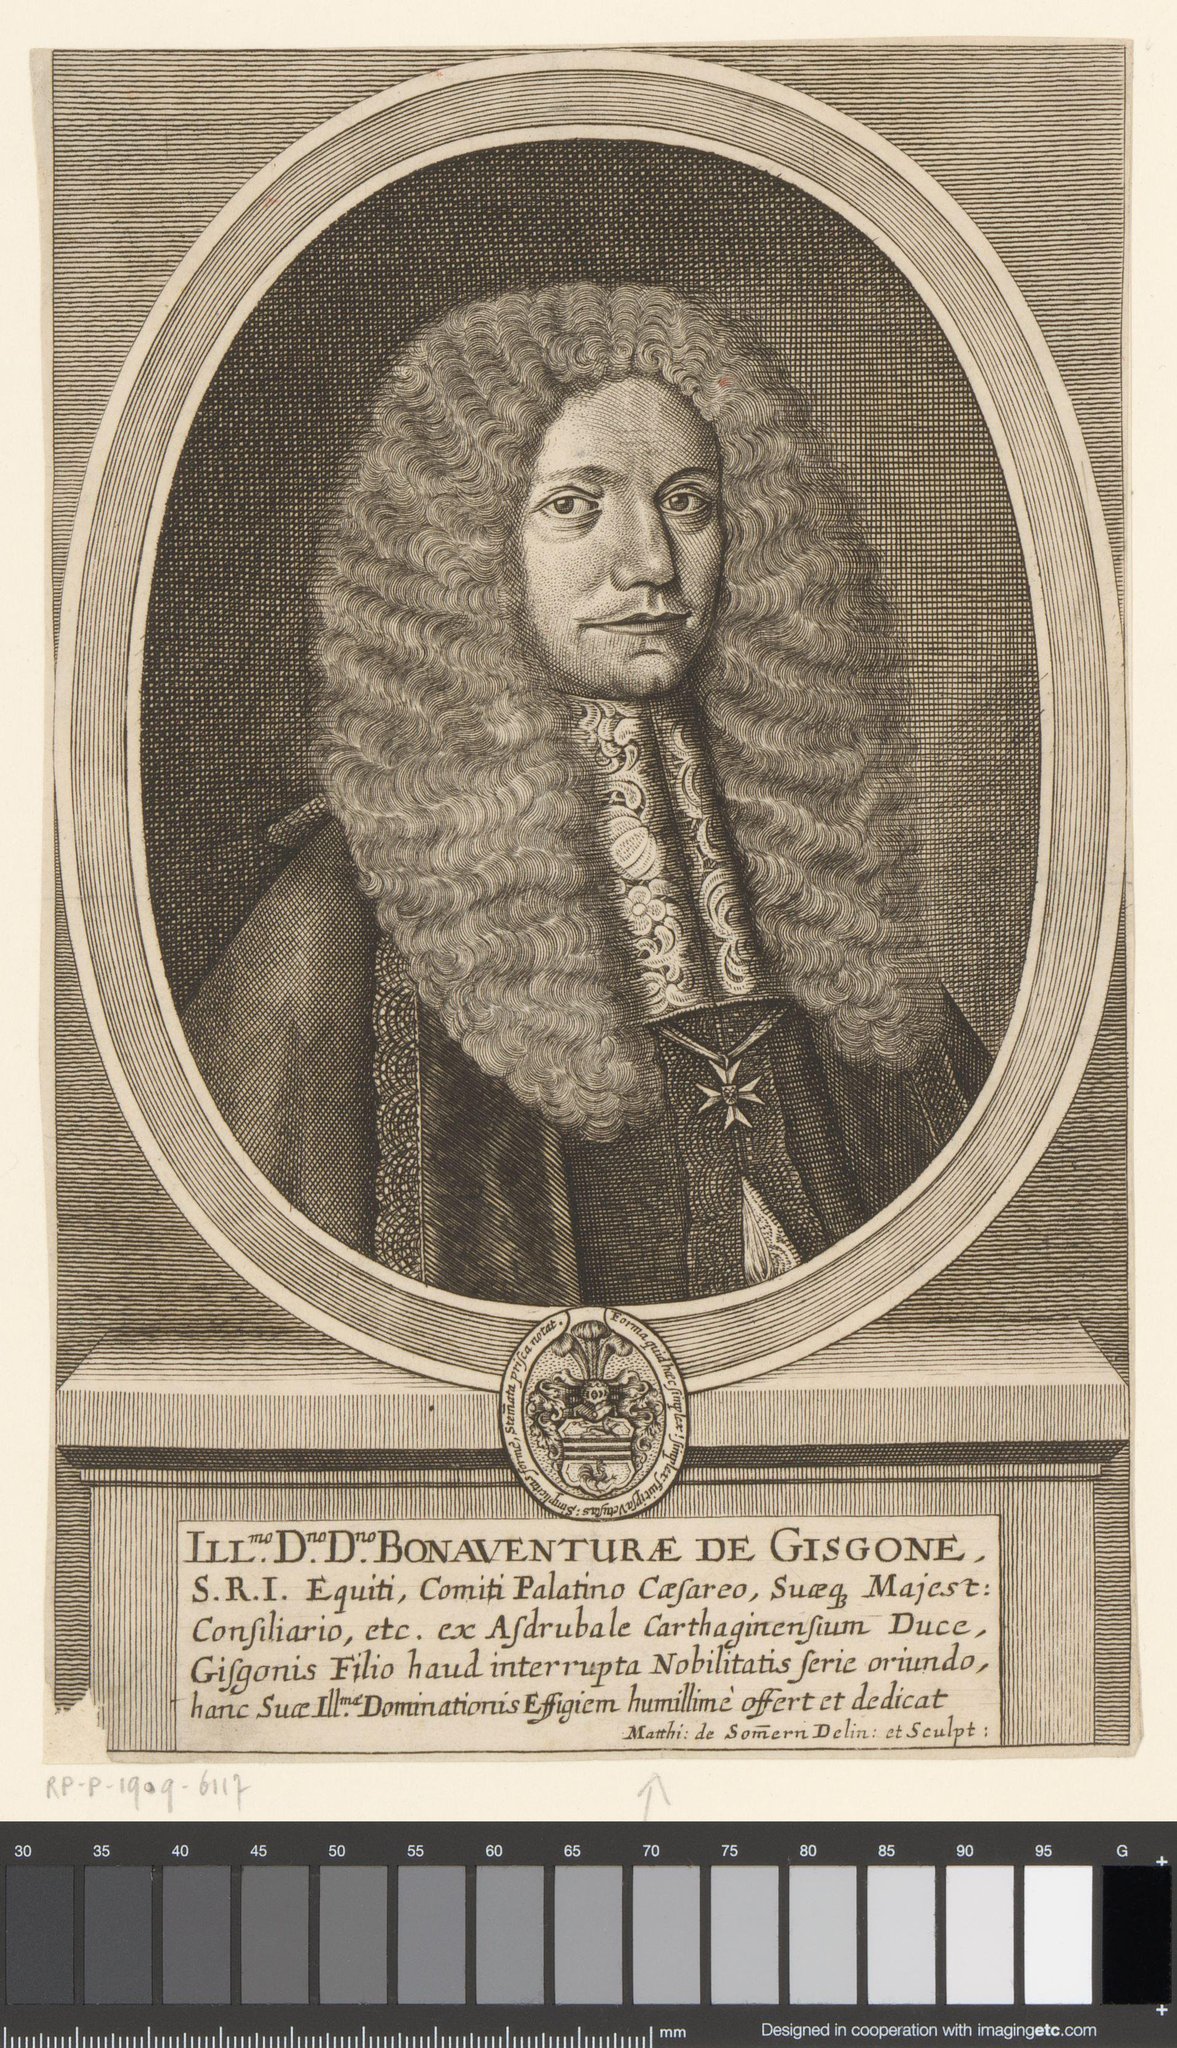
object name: print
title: Portret van Bonaventura de Gisgone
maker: matthias van sommer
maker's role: draughtsman, print maker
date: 1643-1672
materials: paper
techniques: engraving, etching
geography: germany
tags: historical persons, armorial bearing, heraldry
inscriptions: collector's mark: Lugt 2228